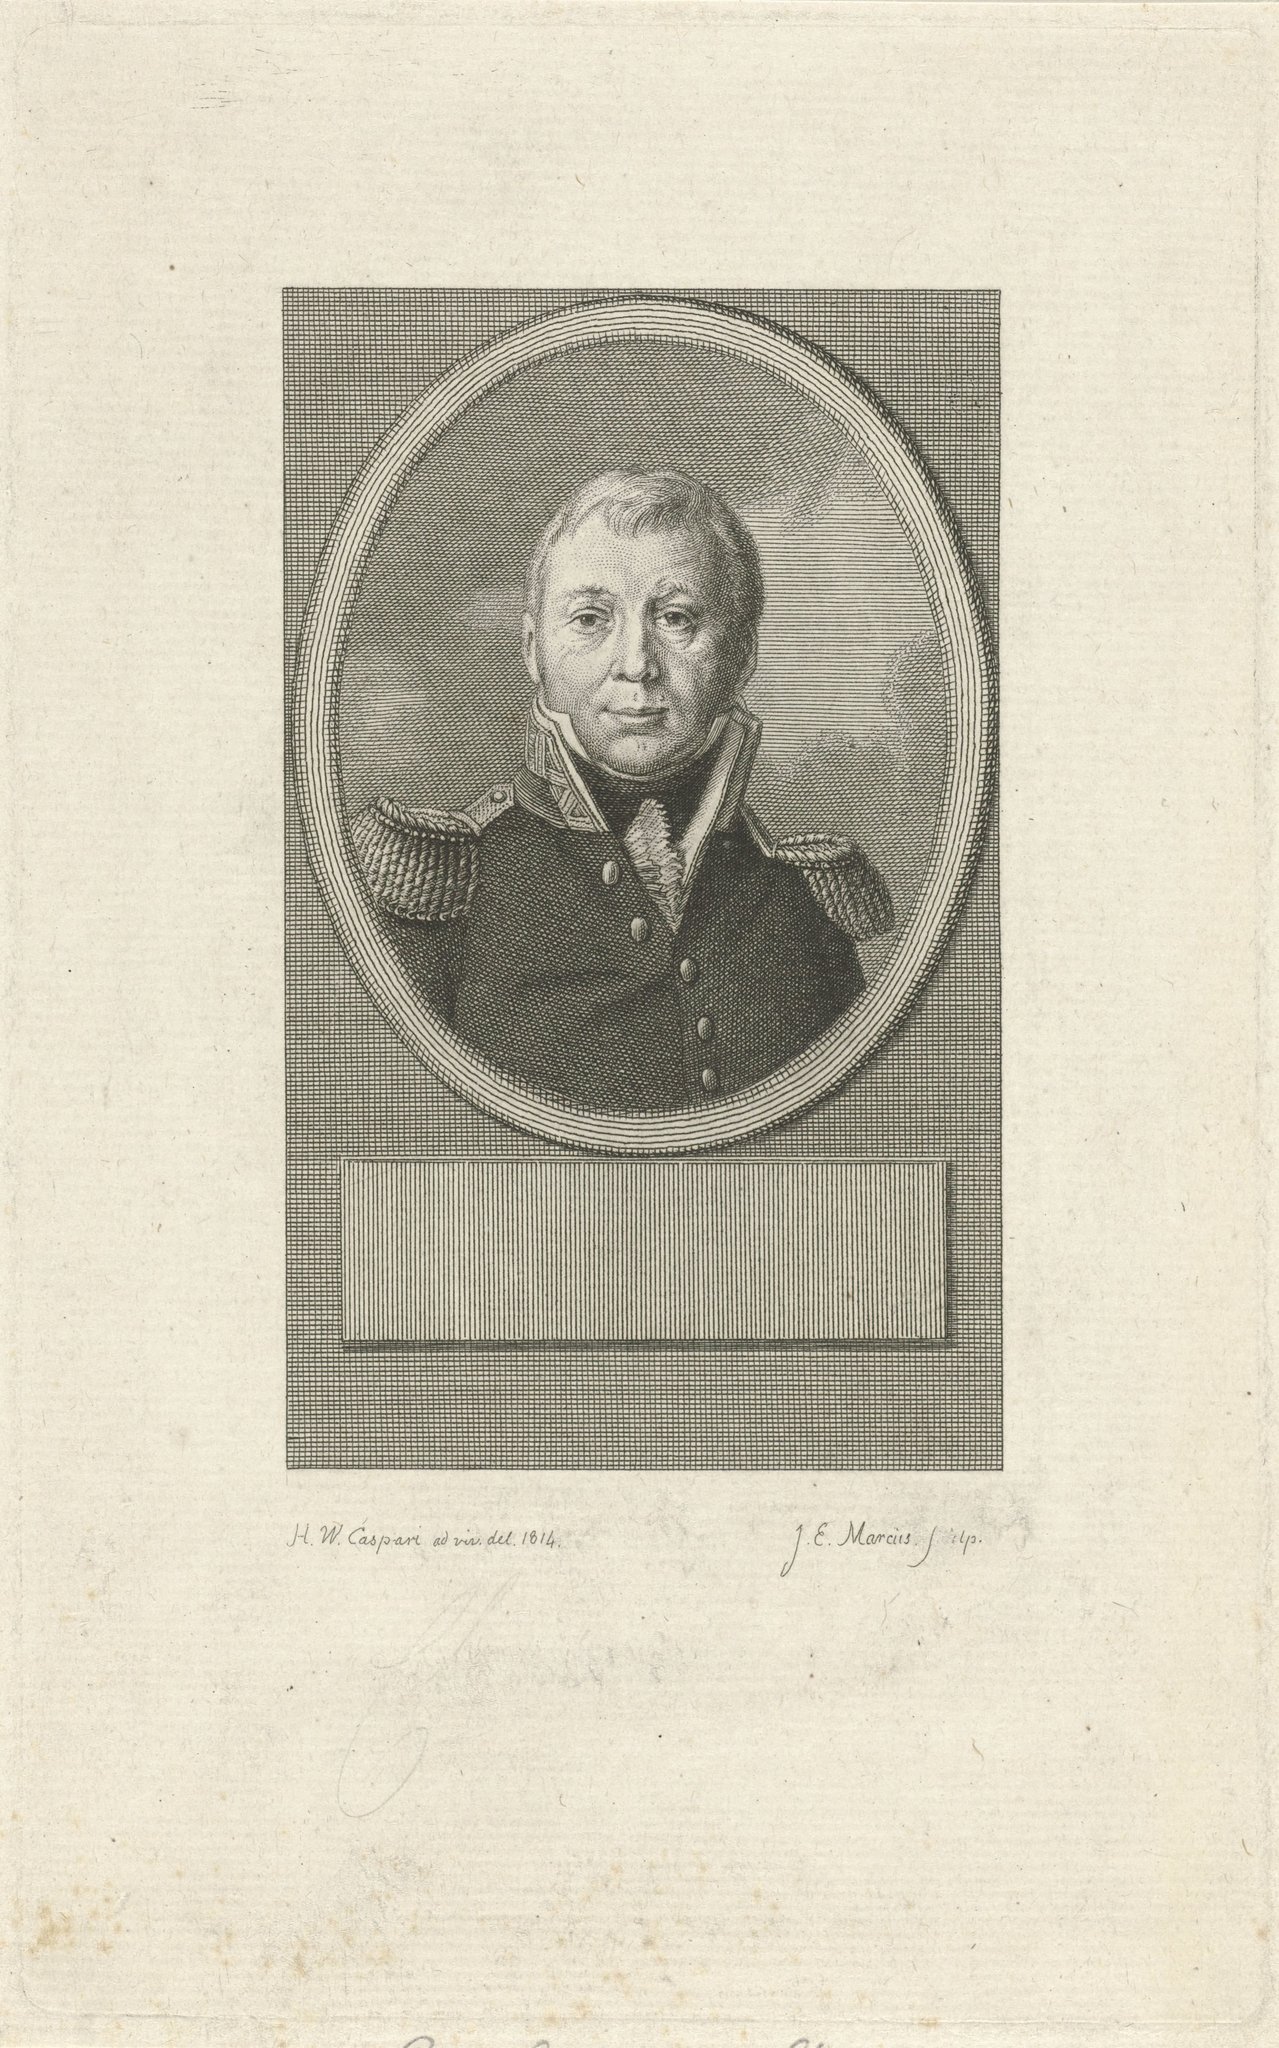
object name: print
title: Portret van Leopold, graaf van Limburg Stirum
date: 1814-1817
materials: paper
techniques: engraving, etching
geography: amsterdam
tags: the hague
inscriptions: collector's mark: Lugt 2228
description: Latere staat van de prent ook gebruikt in: Herman Bosscha, Geschiedenis der Nederlandsche staatsomwenteling in 1813. 4 dln. Amsterdam: P. den Hengt en zn. en J. van der Hey, 1817.